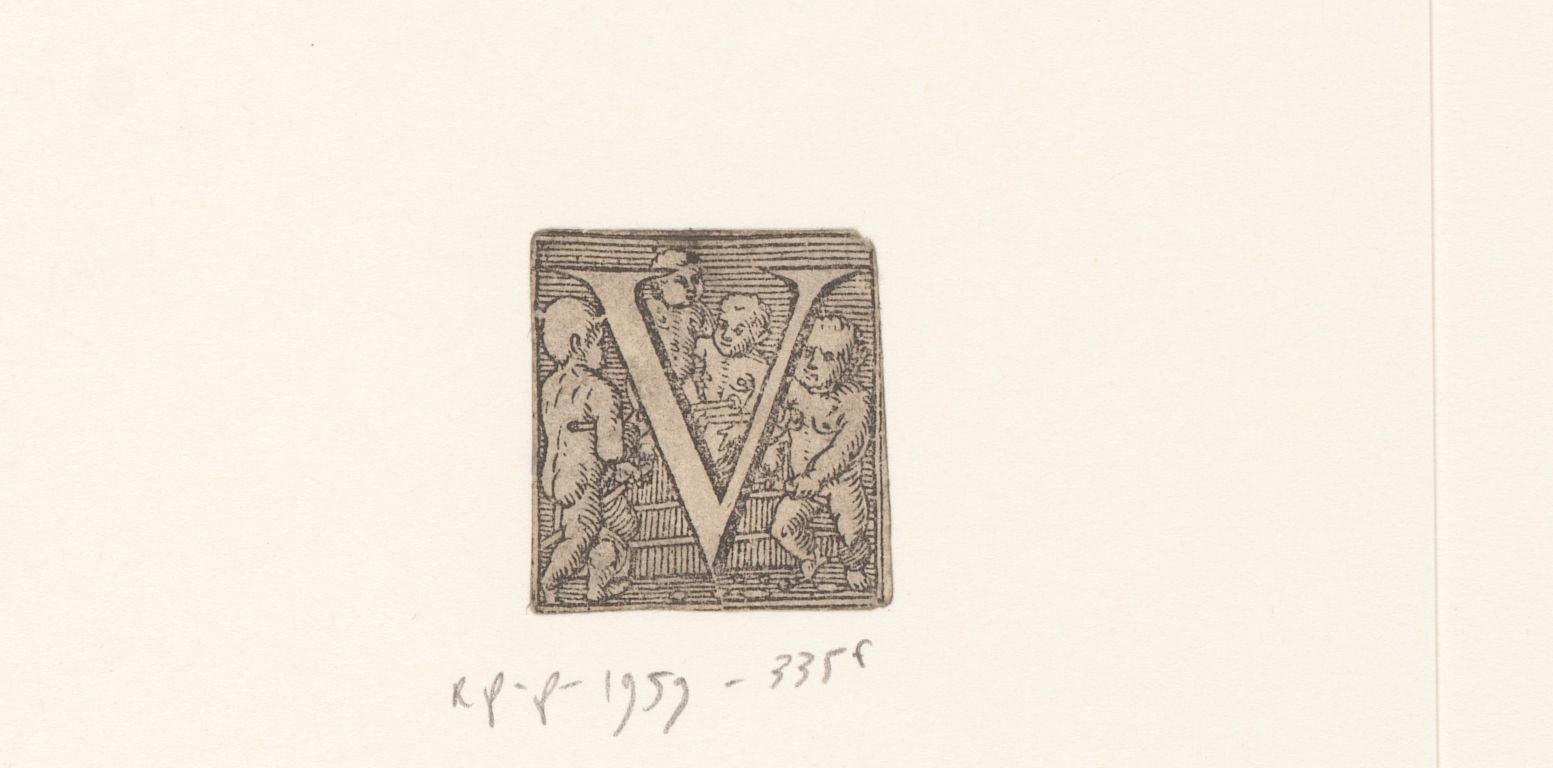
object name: print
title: Versierde letter V met spelende naakte kinderen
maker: Anonymous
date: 1500-1599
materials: paper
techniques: woodcut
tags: initial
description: Prent afkomstig uit een onbekende publicatie.